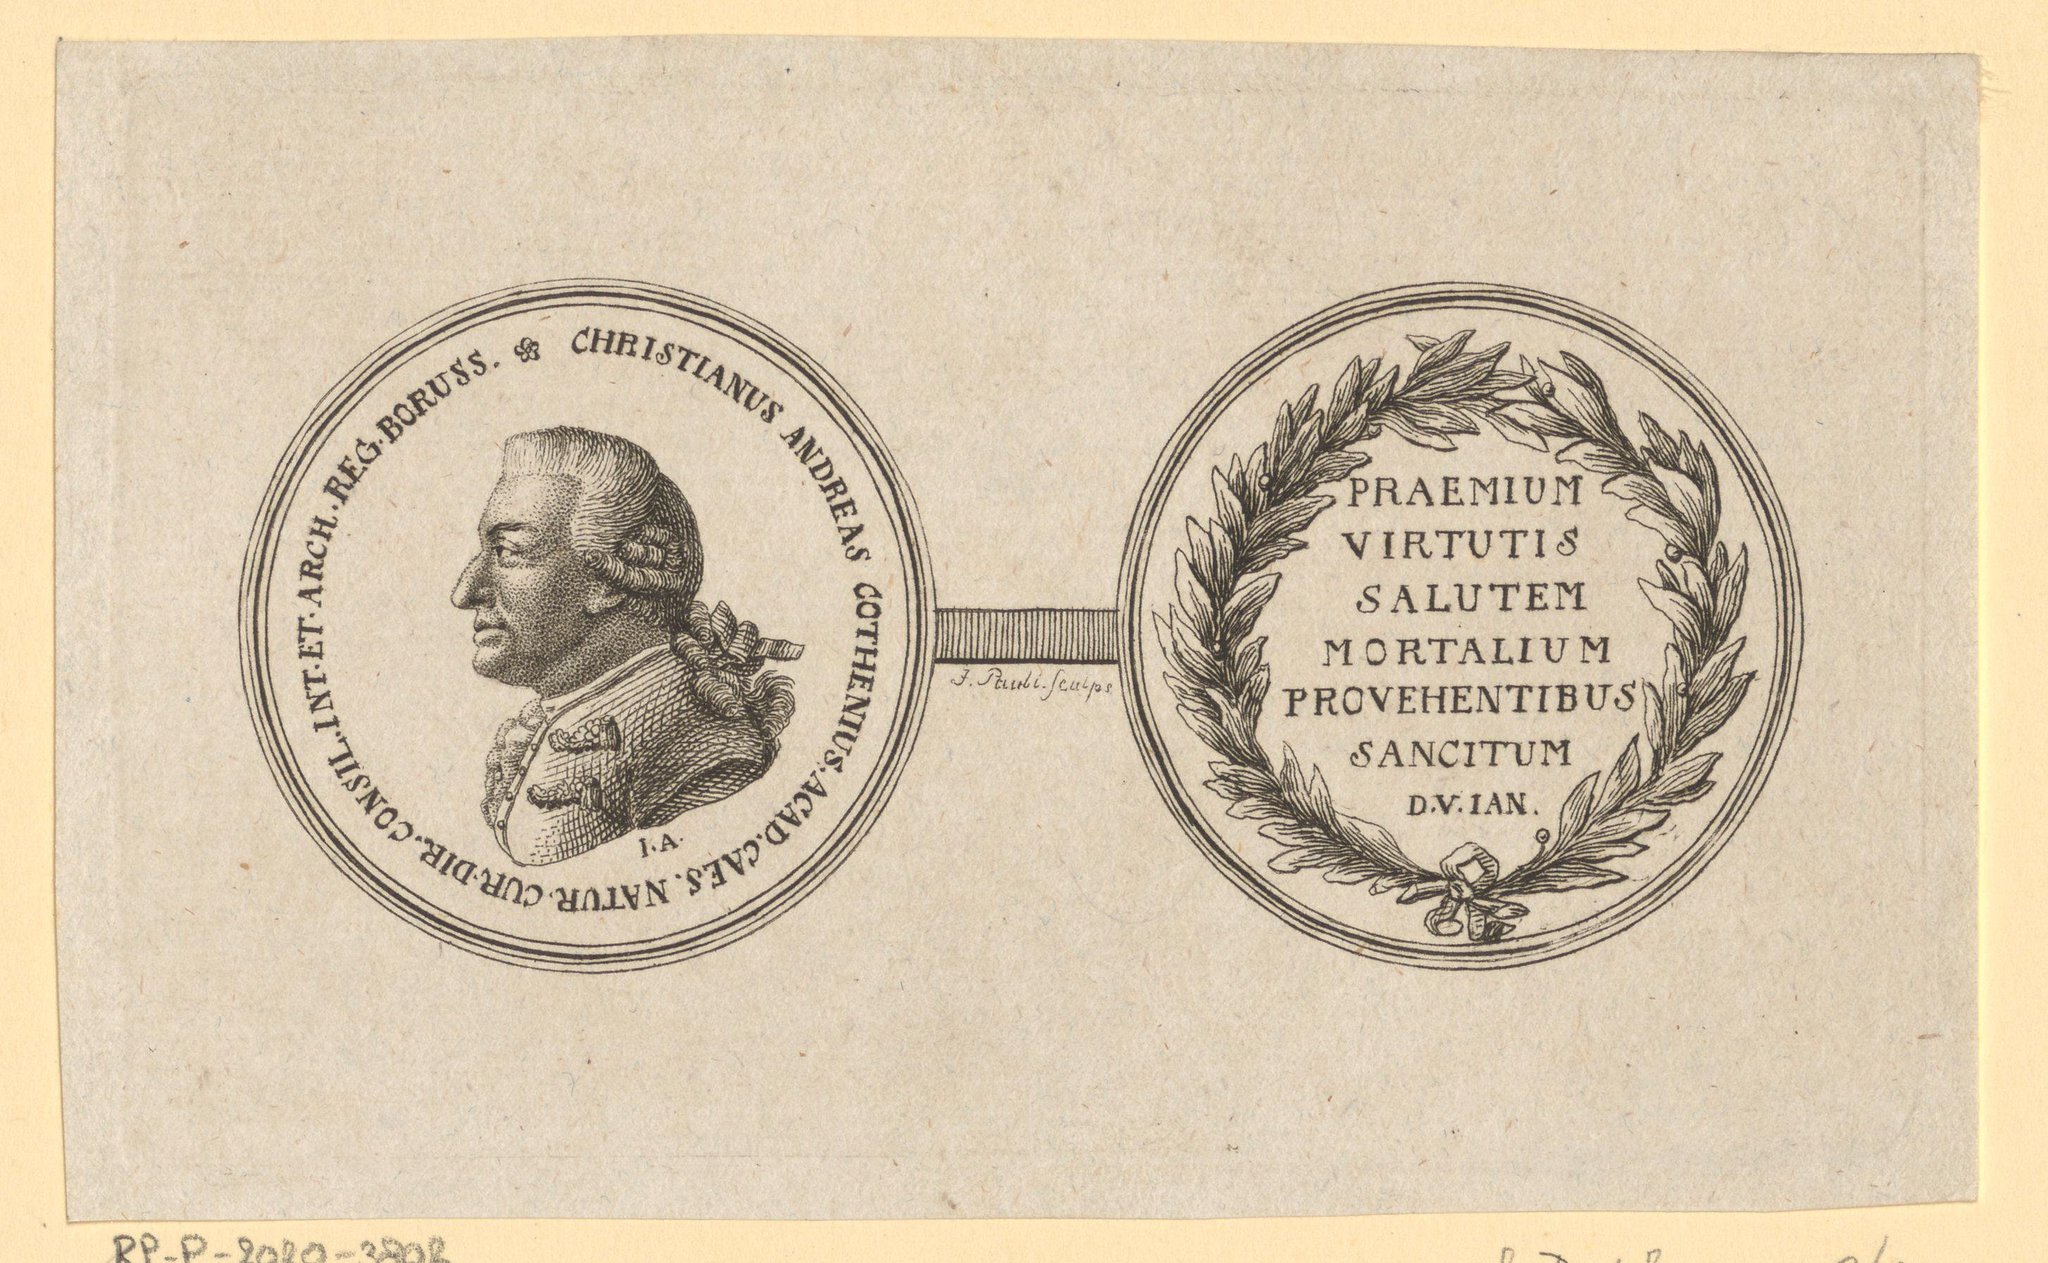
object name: print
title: Medaille met het portret van Christian Andreas Cothenius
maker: philippe joseph jacoby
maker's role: graveur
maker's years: 1708-1794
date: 1792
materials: paper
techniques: etching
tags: berlin, historical persons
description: Het ontwerp van de Cothenius-medaille die wordt uitgereikt als wetenschapsprijs door de Deutsche Akademie der Naturforscher Leopoldina.